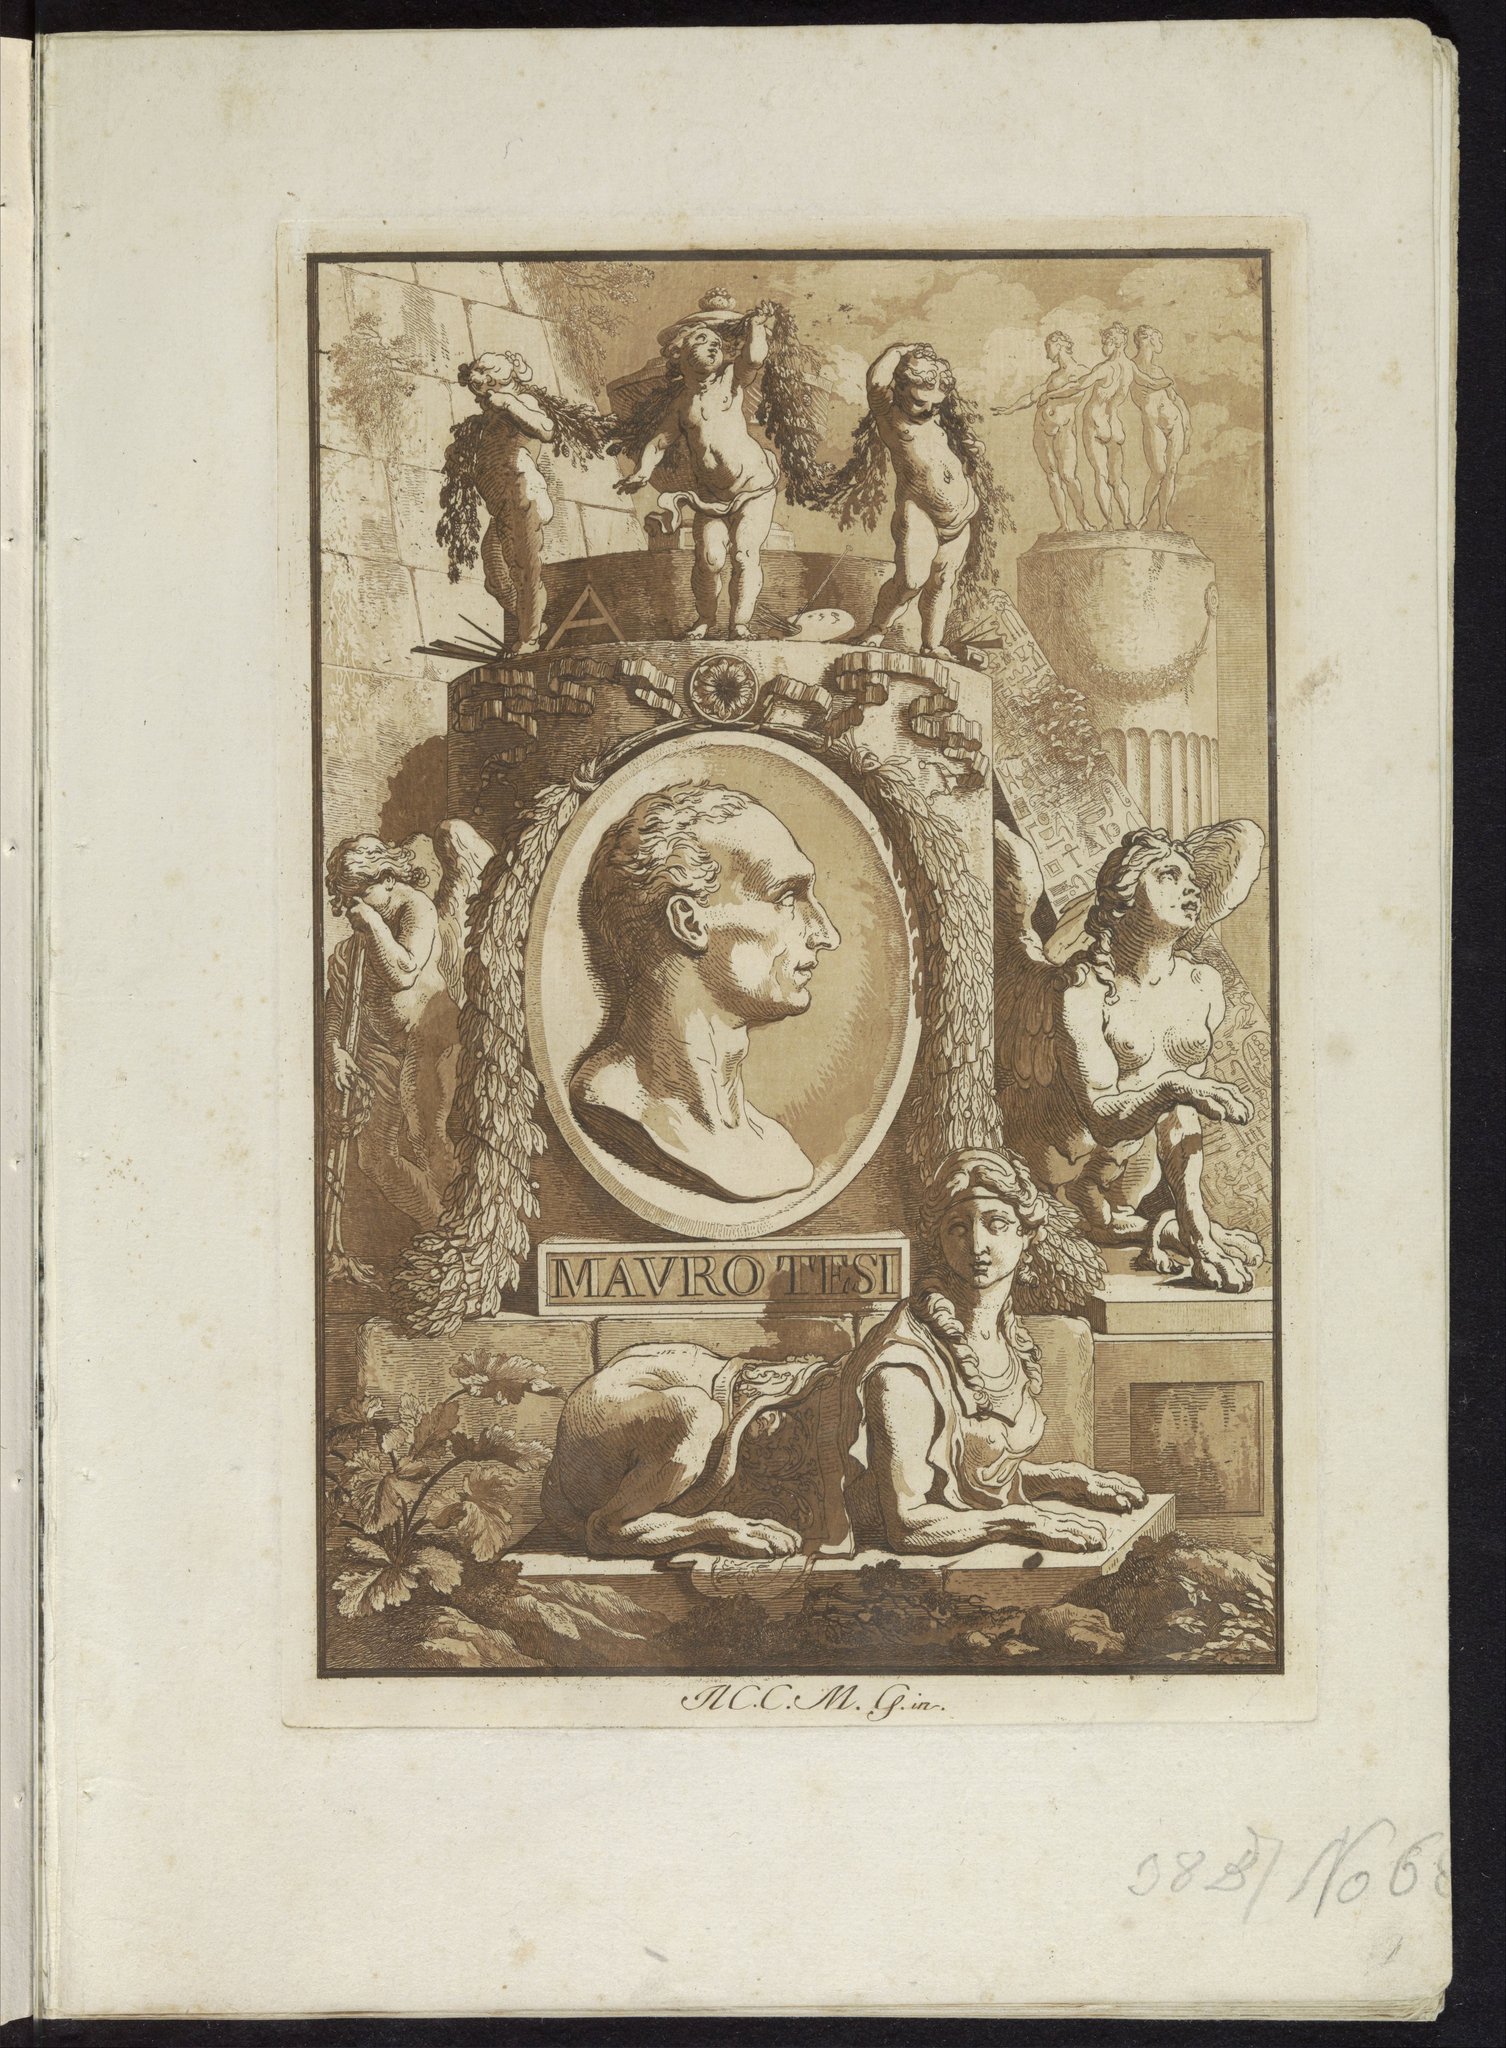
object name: print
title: Portret van Mauro Tesi in medaillon omringd door sculpturale en architectonische elementen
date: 1787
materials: paper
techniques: aquatint, etching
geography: bologna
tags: print maker, mauro antonio tesi, historical persons, portrait, self-portrait of artist